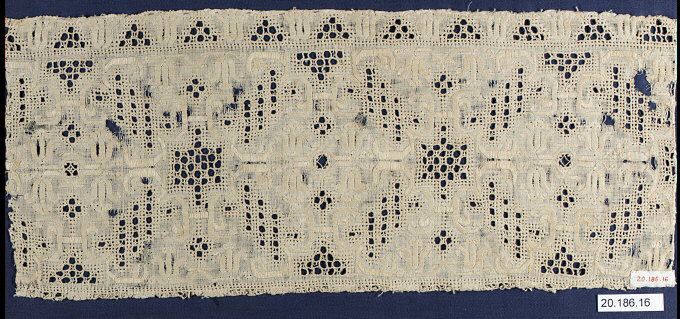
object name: strip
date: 1501-1600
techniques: embroidery